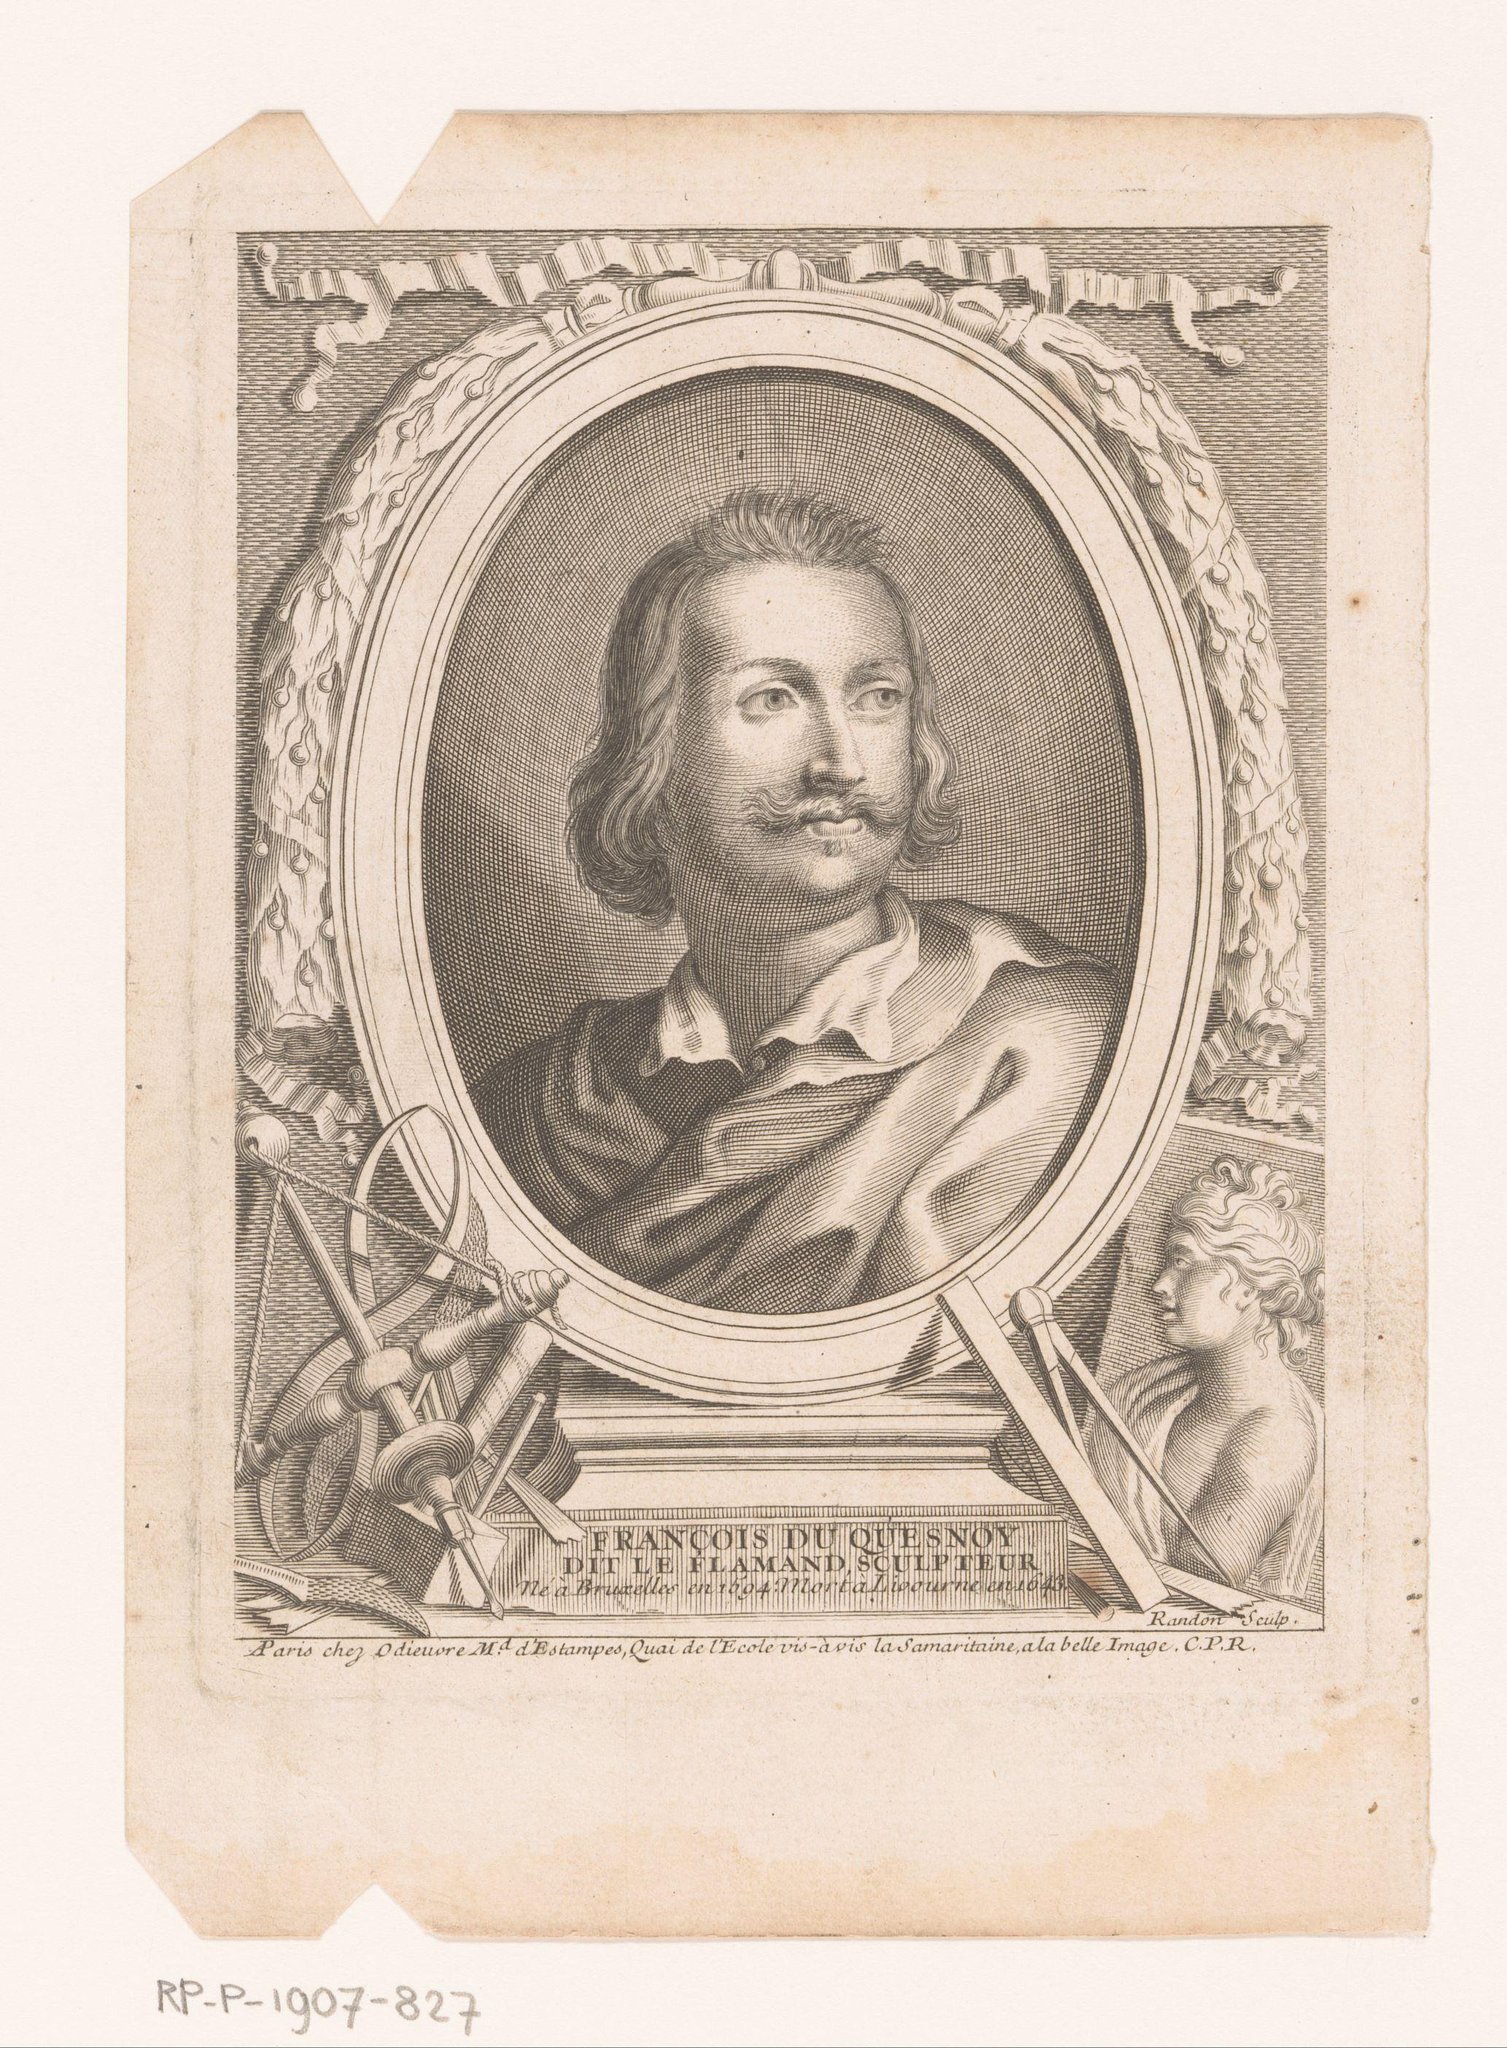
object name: print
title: Portret van François Du Quesnoy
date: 1648-1670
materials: paper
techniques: engraving, etching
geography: france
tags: draughtsman, sculptor, françois du quesnoy, historical persons, portrait, self-portrait of artist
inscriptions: collector's mark: Lugt 2228